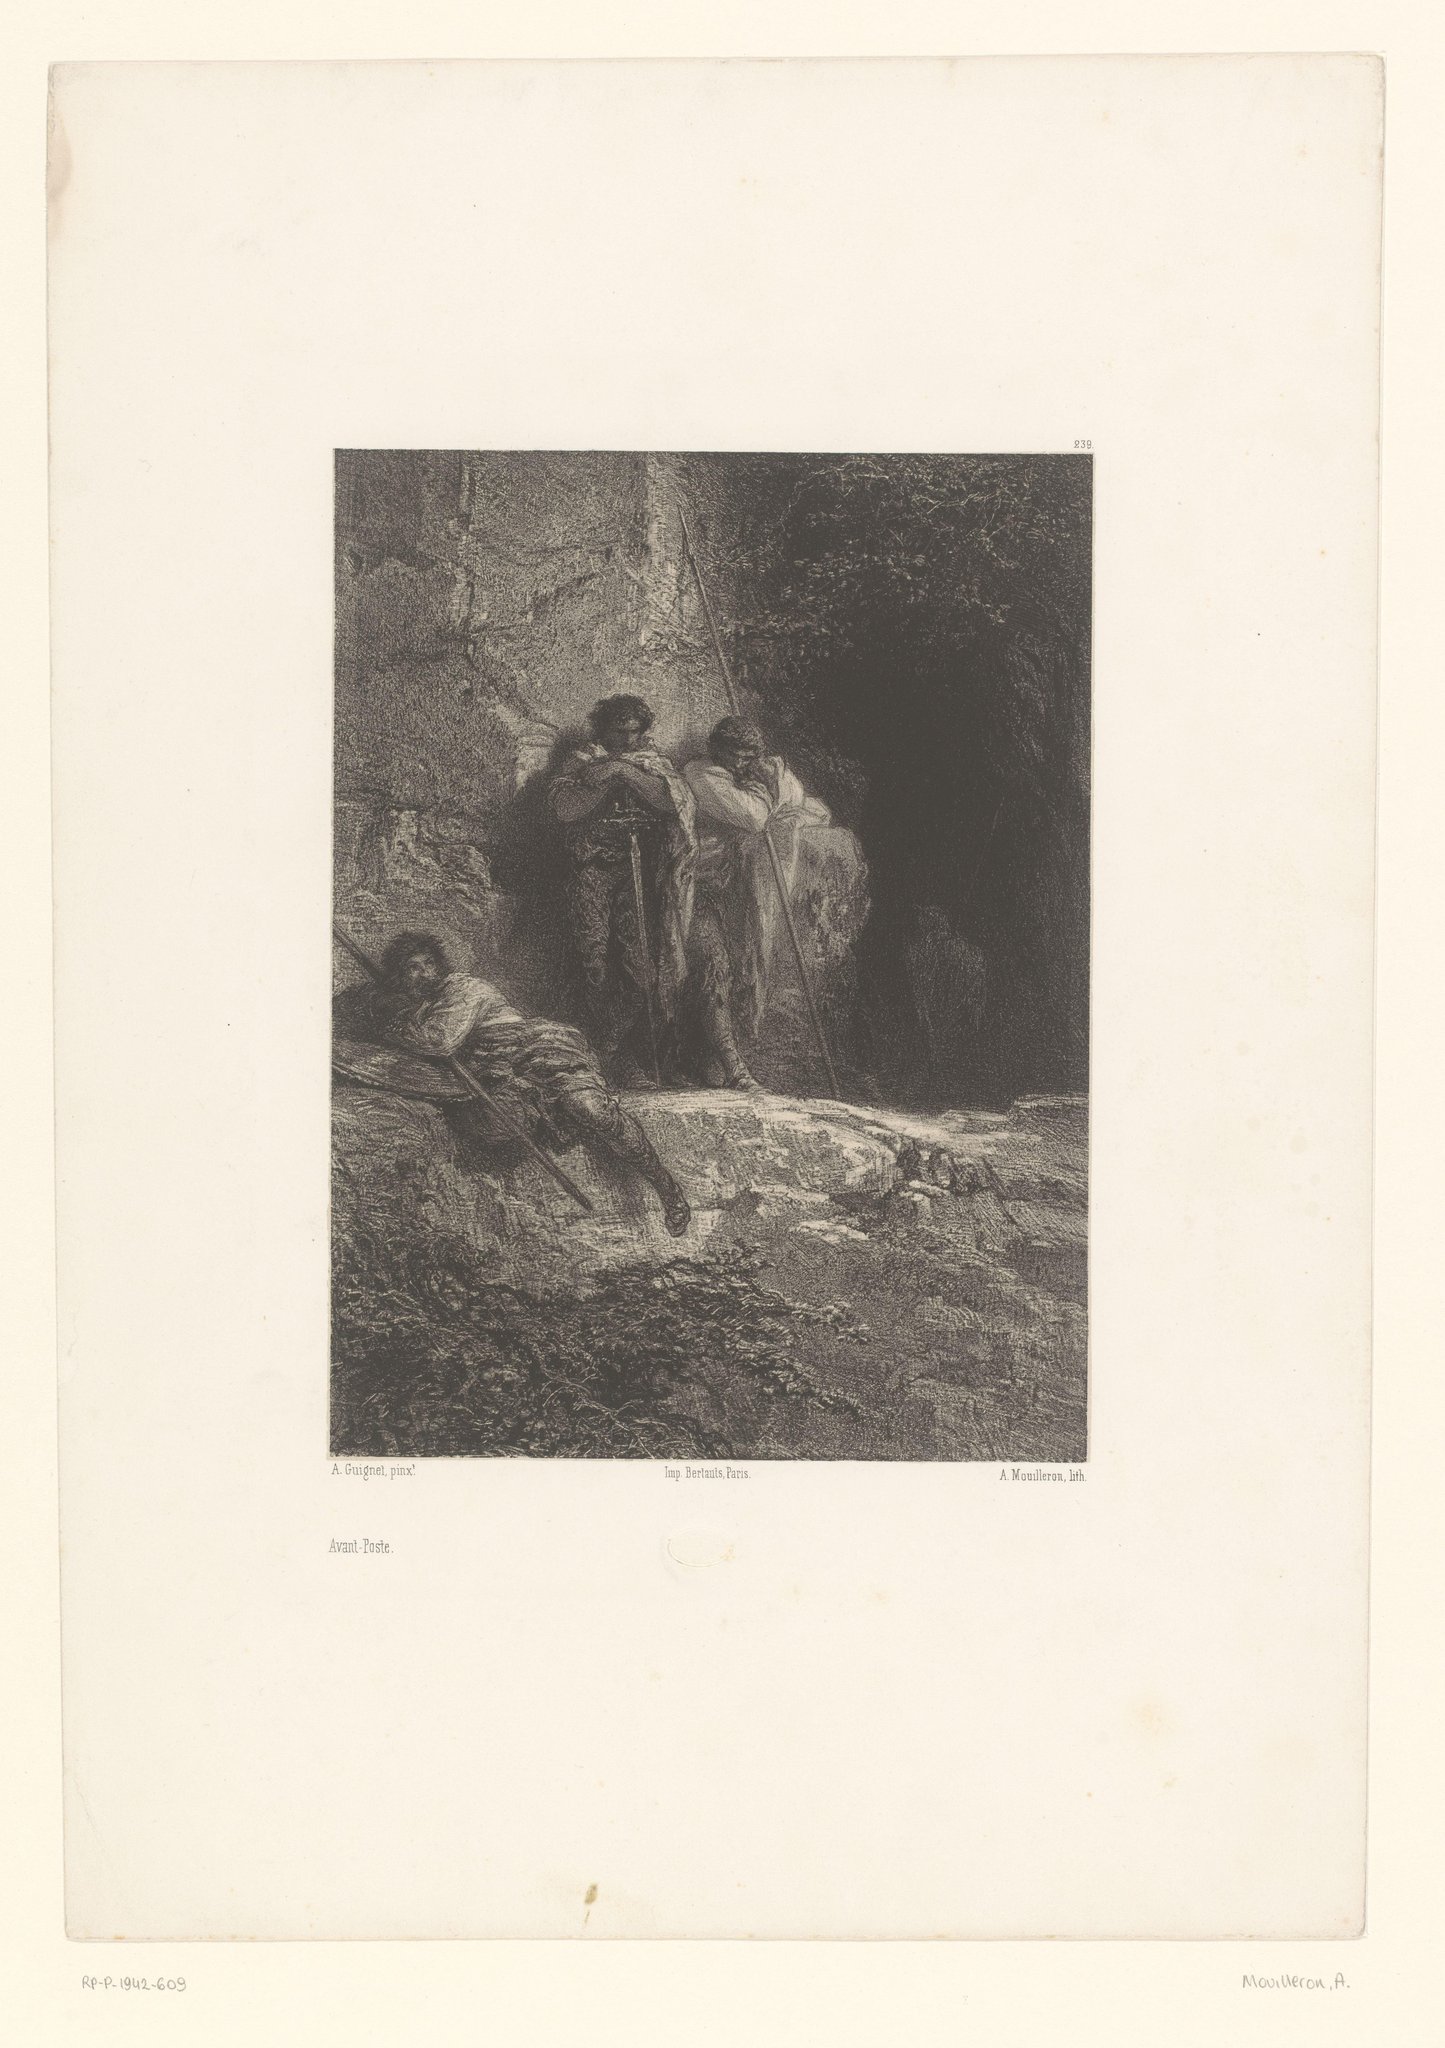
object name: print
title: Avant-poste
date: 1848-1862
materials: paper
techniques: lithograph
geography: paris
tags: guard duty, keeping sentry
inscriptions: collector's mark: Lugt 2228, check stamp: Lugt 36a